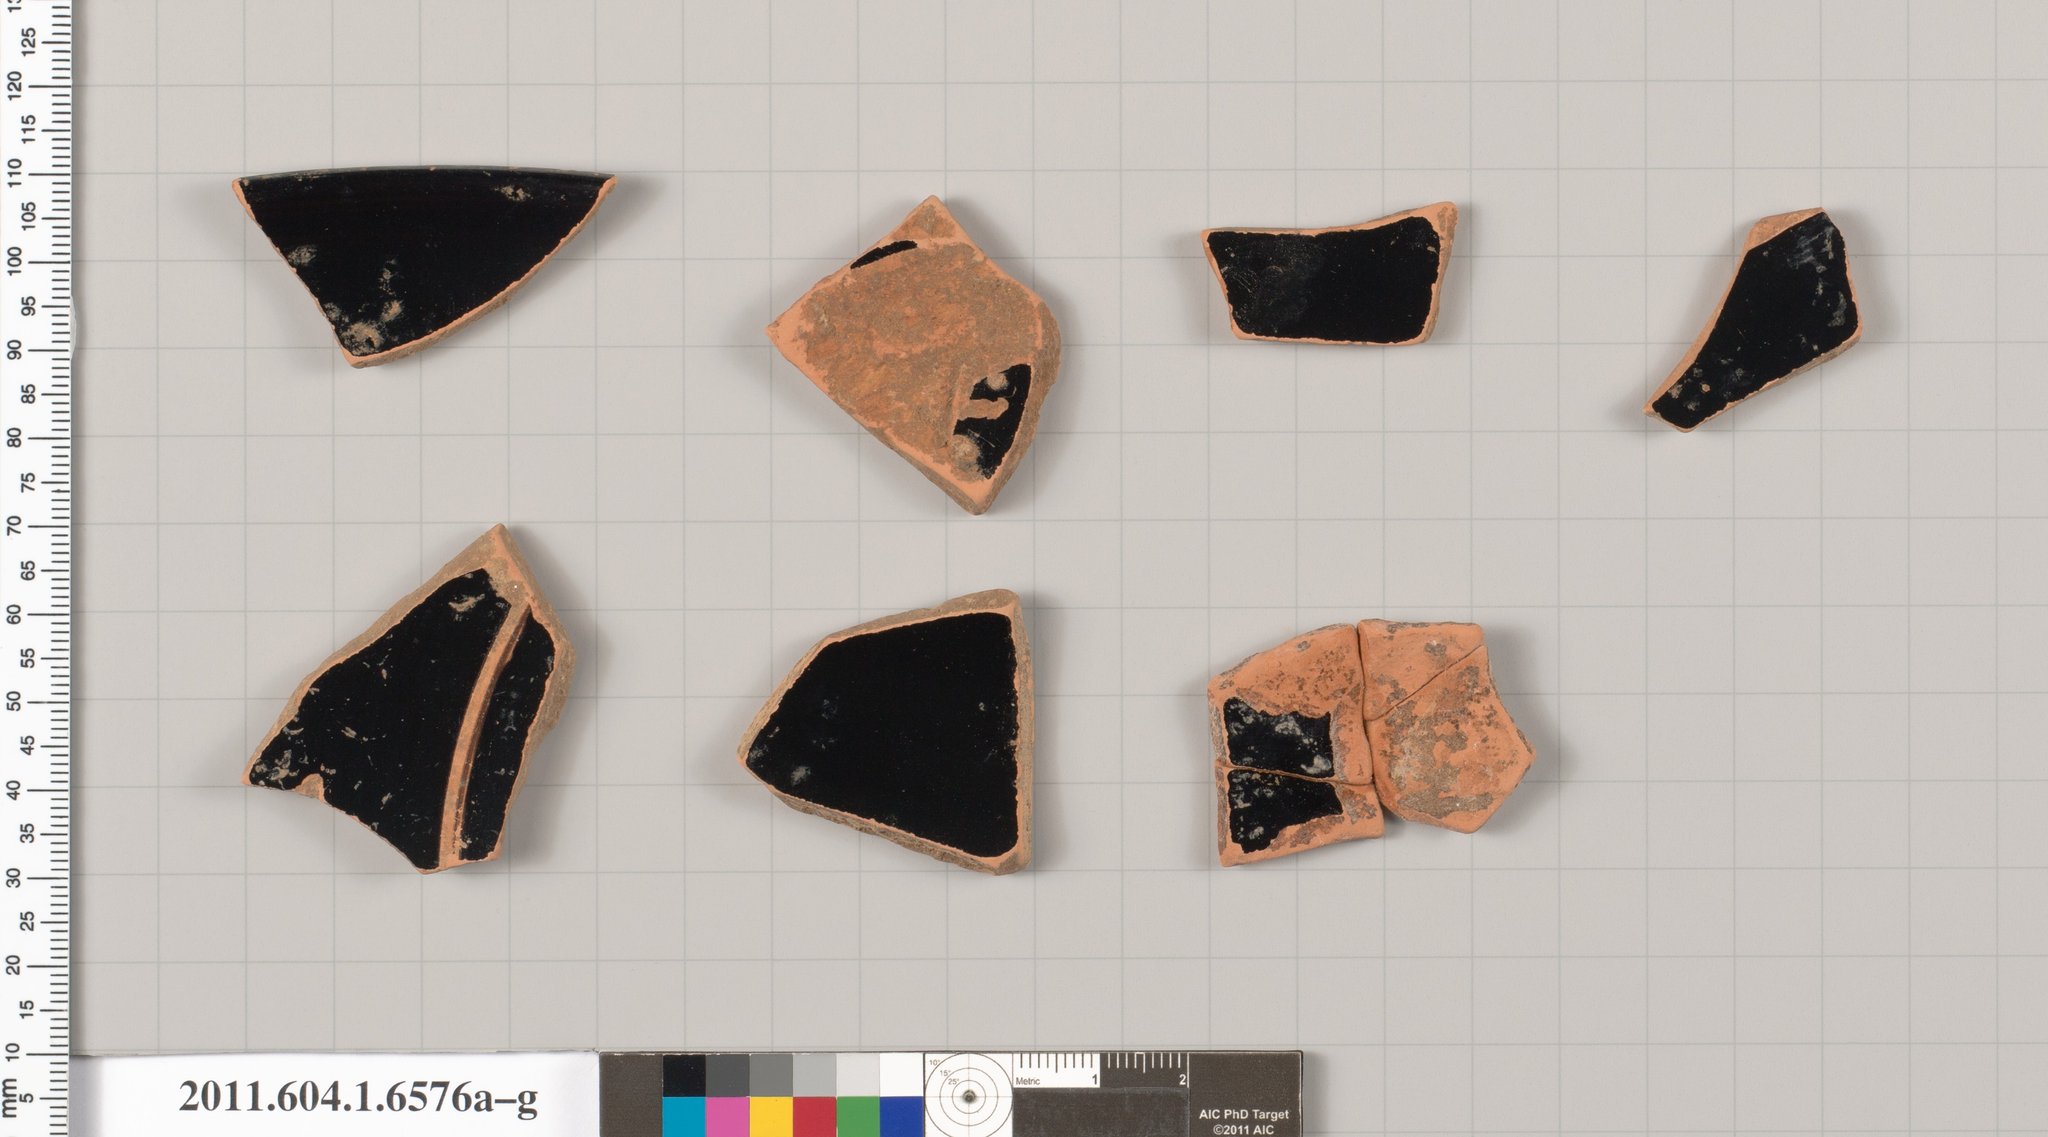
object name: kylix fragment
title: Terracotta fragments of a kylix (drinking cup)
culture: greek, attic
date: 490-480 BCE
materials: terracotta